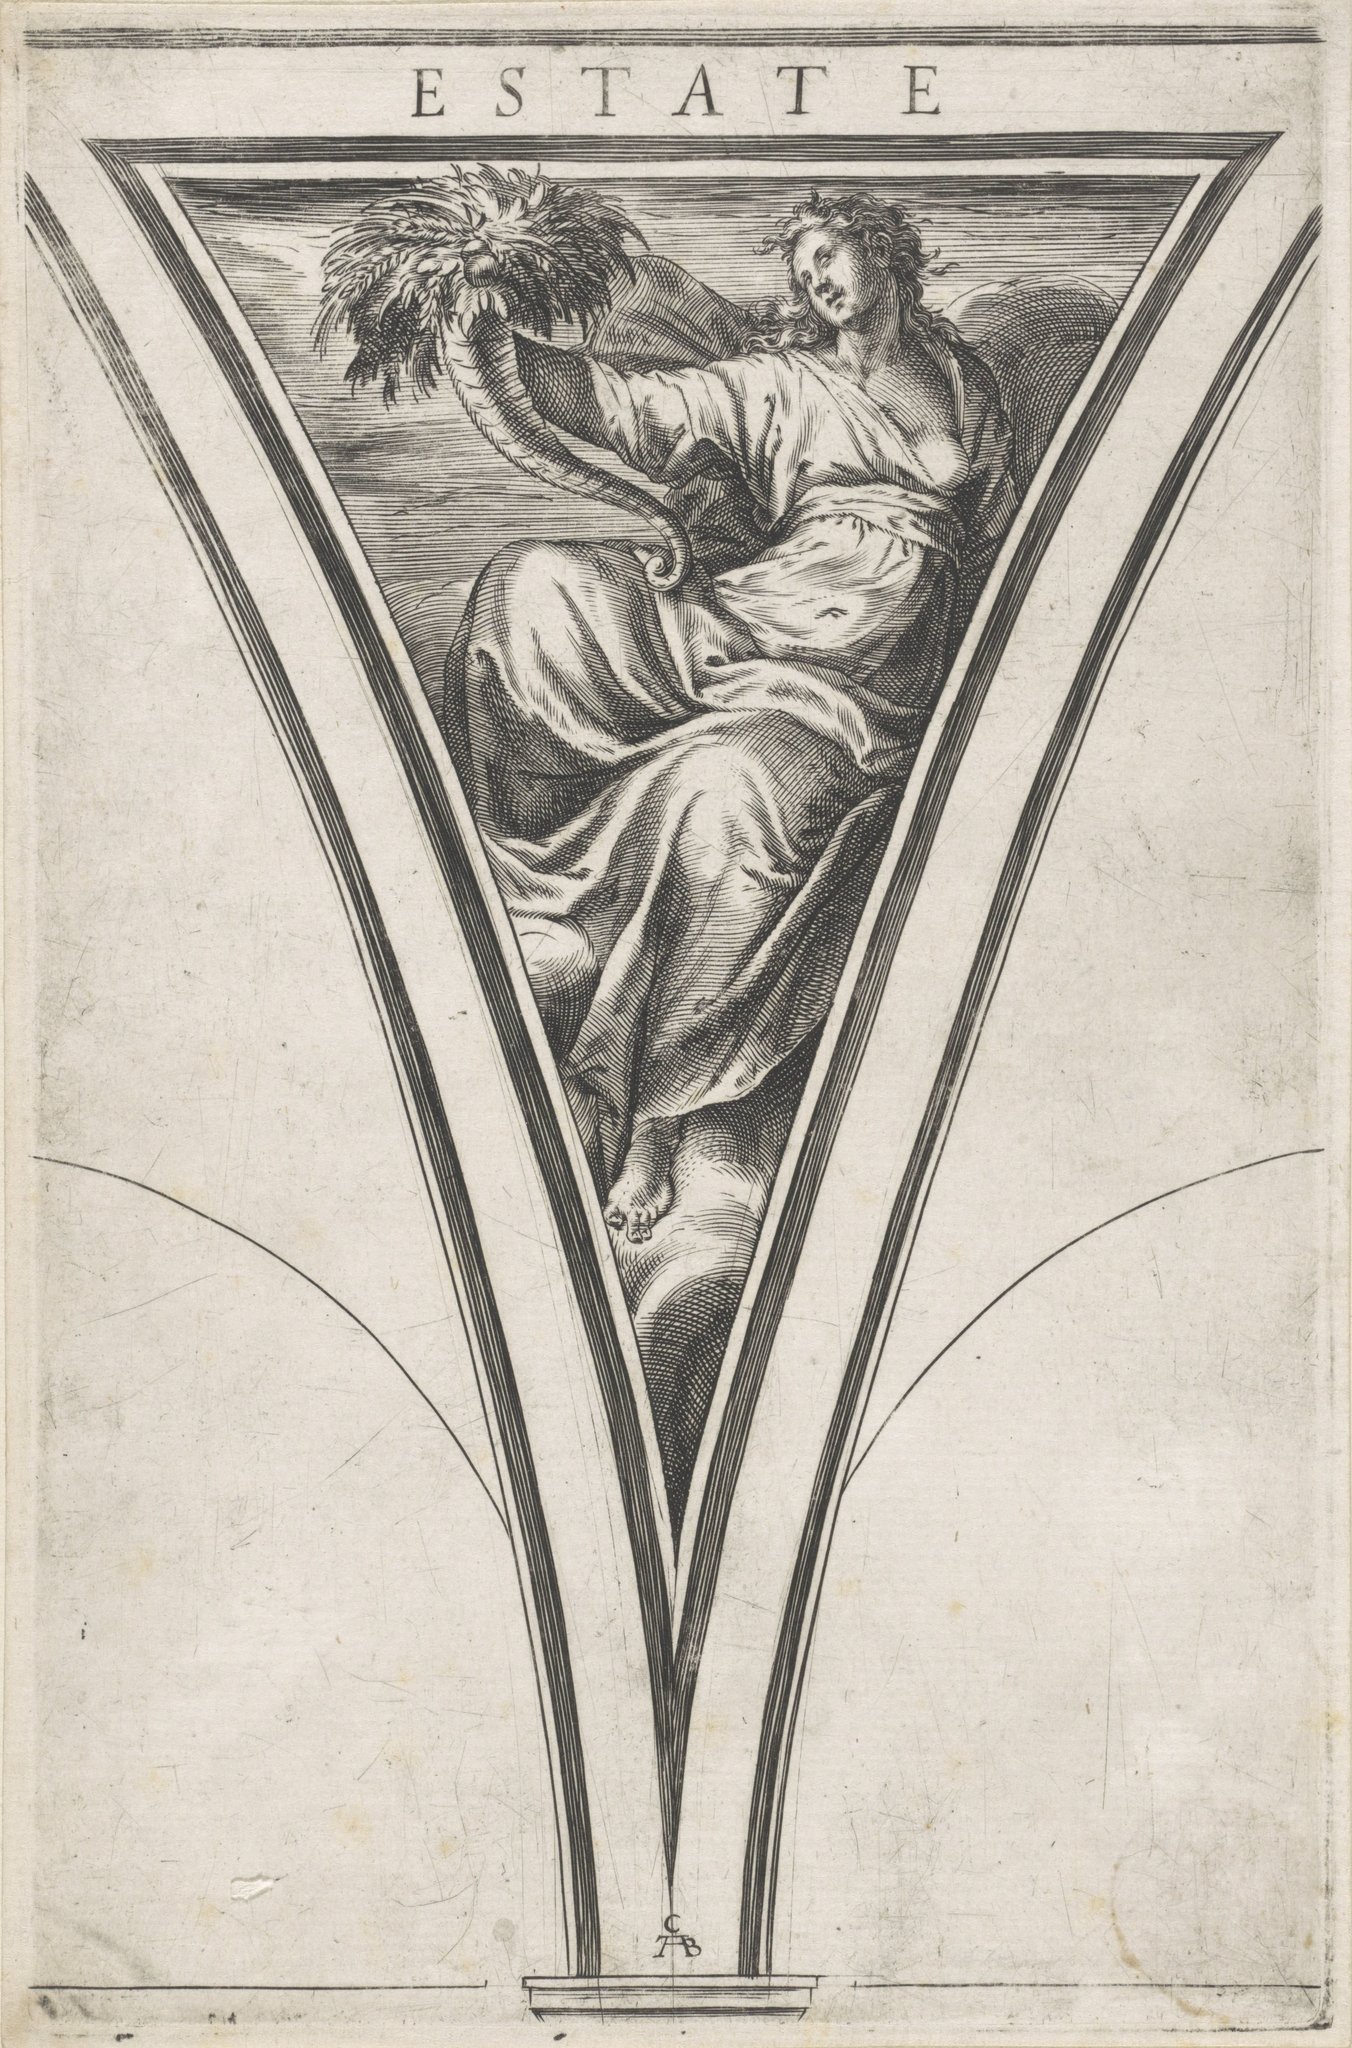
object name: print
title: Vier seizoenen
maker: cherubino alberti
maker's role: draughtsman, print maker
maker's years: 1553-1615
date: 1563-1615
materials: paper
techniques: engraving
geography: italy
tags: summer, 'aestas'; 'estate' (ripa)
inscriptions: collector's mark: Lugt 240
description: Prent uit een reeks van vier prenten (+ titelprent) van de vier seizoenen door Cherubino Alberti (Bartsch 101-104).